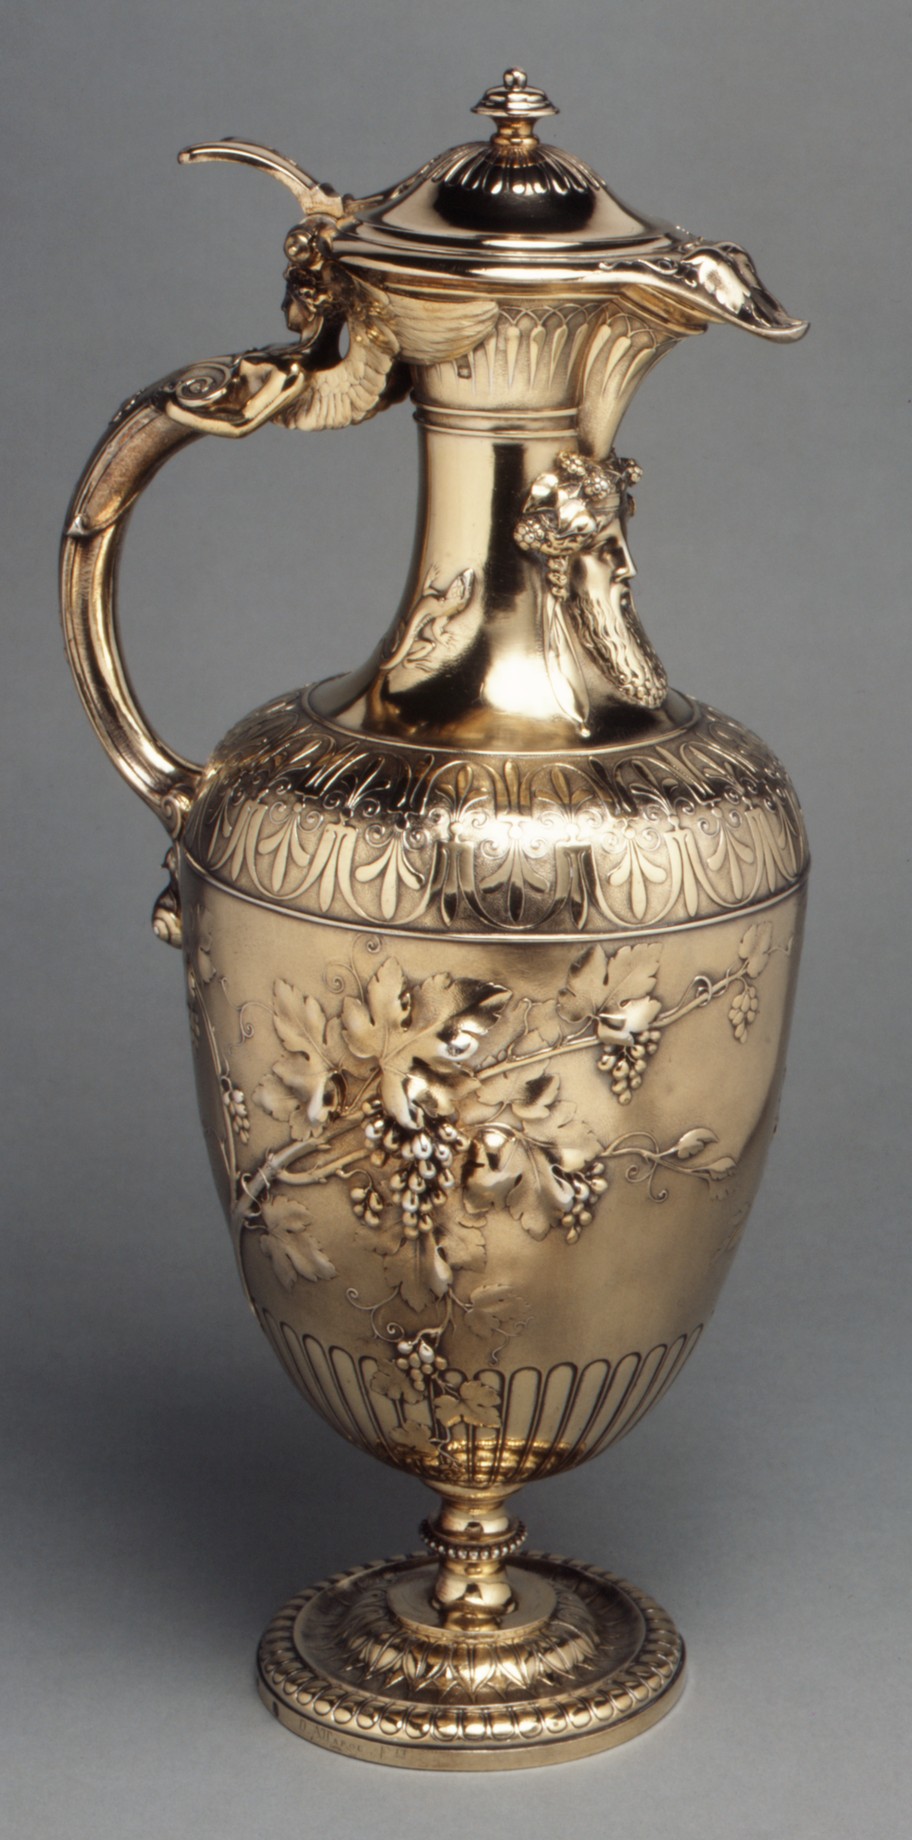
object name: ewer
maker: ferdinand barbedienne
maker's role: manufactory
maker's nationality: french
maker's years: 1810-1892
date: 1875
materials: silver gilt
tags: human figures,animals,grapes